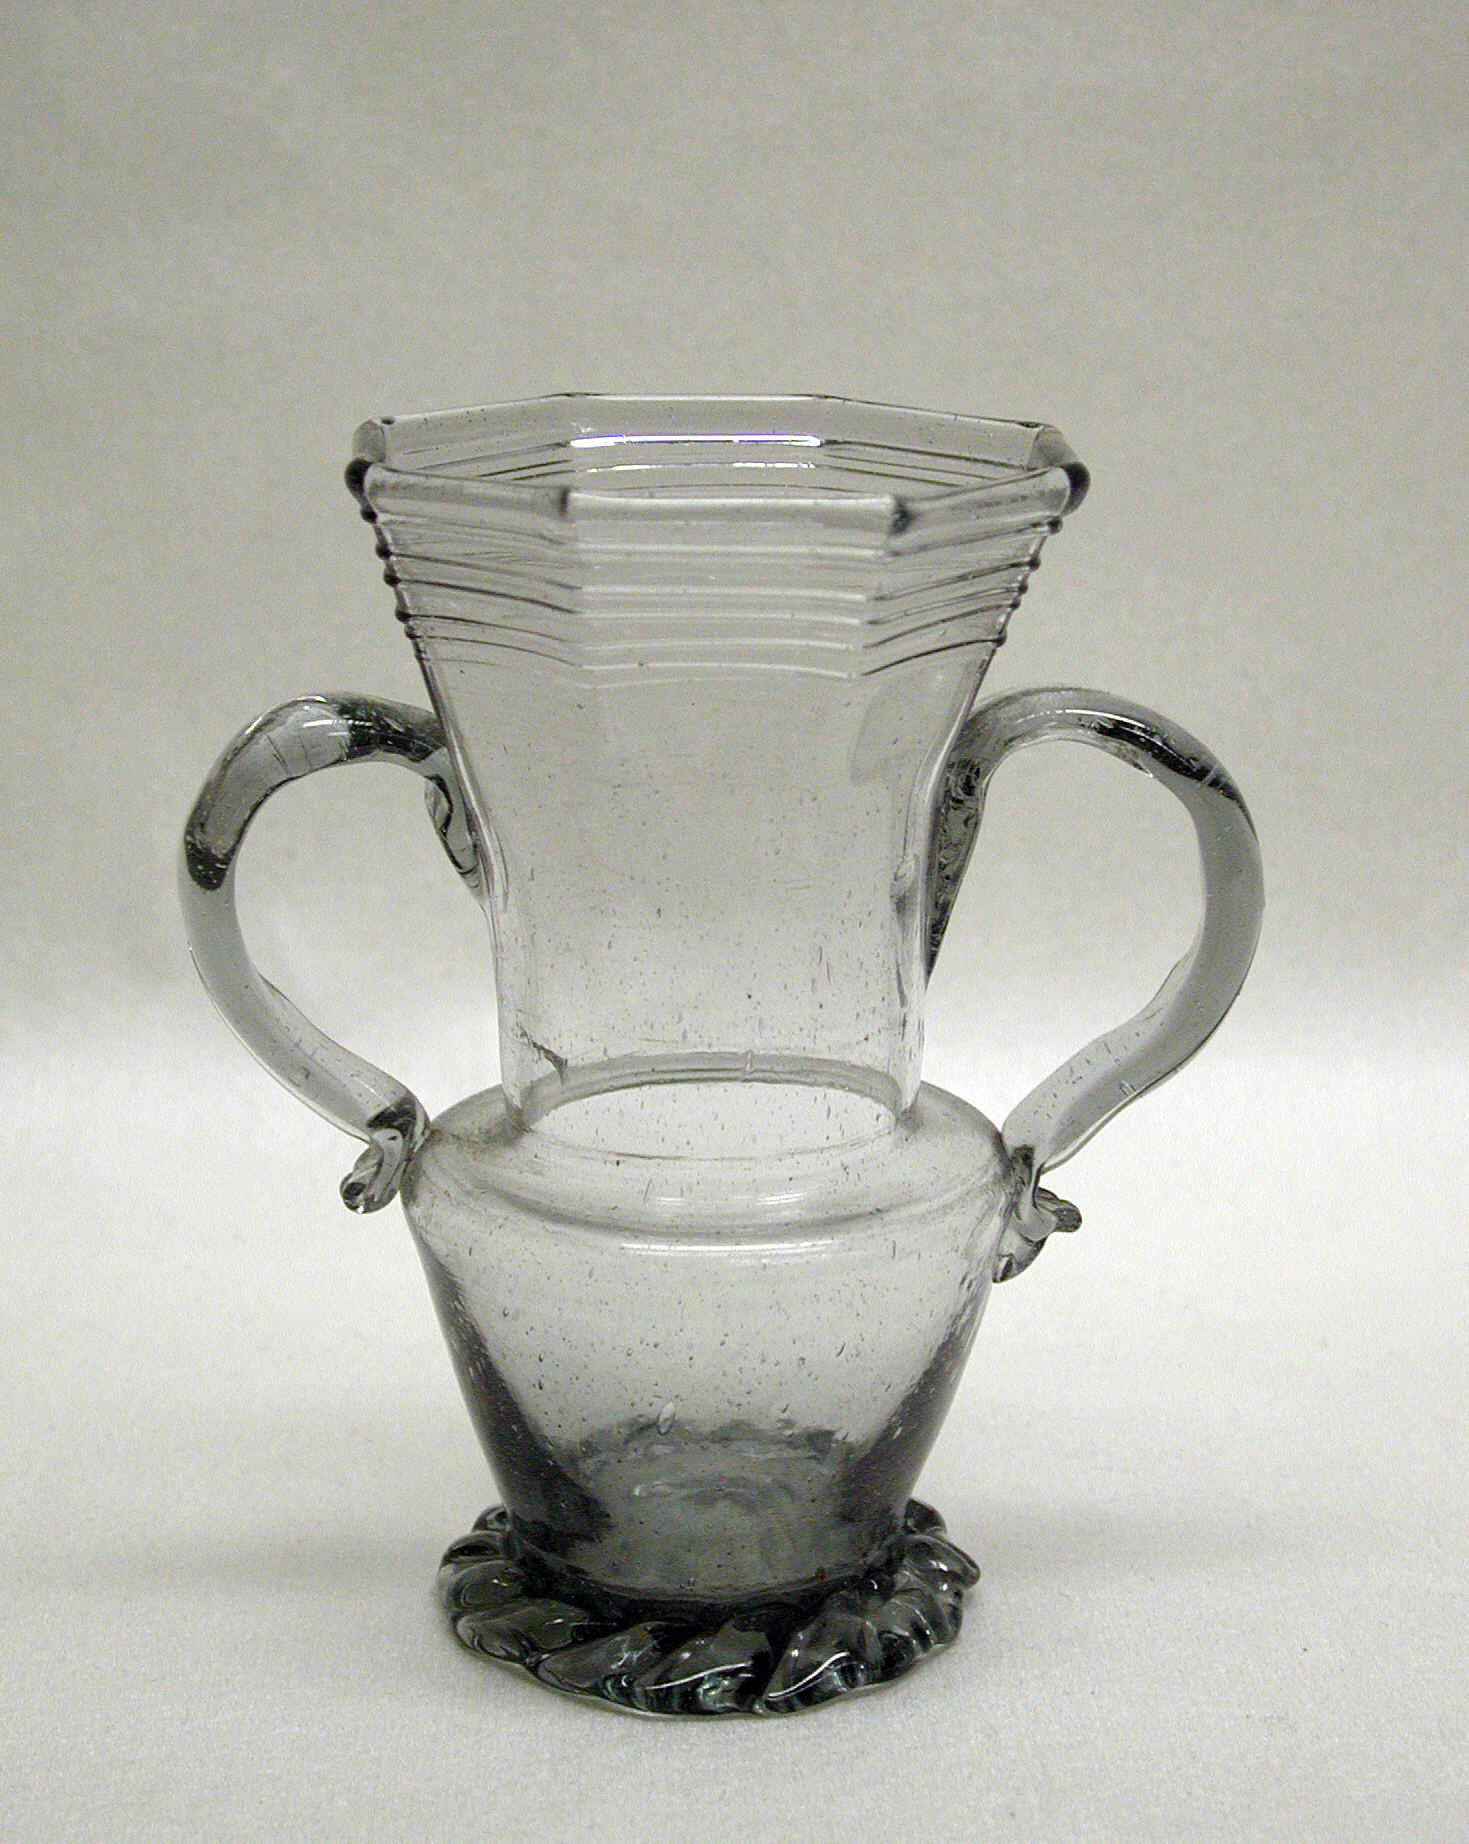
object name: vase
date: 1601-1800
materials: glass